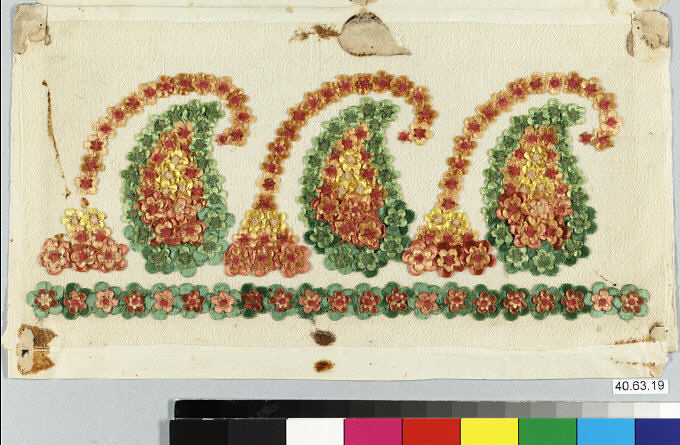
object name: border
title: Dress border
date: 1801-1833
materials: silk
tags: flowers